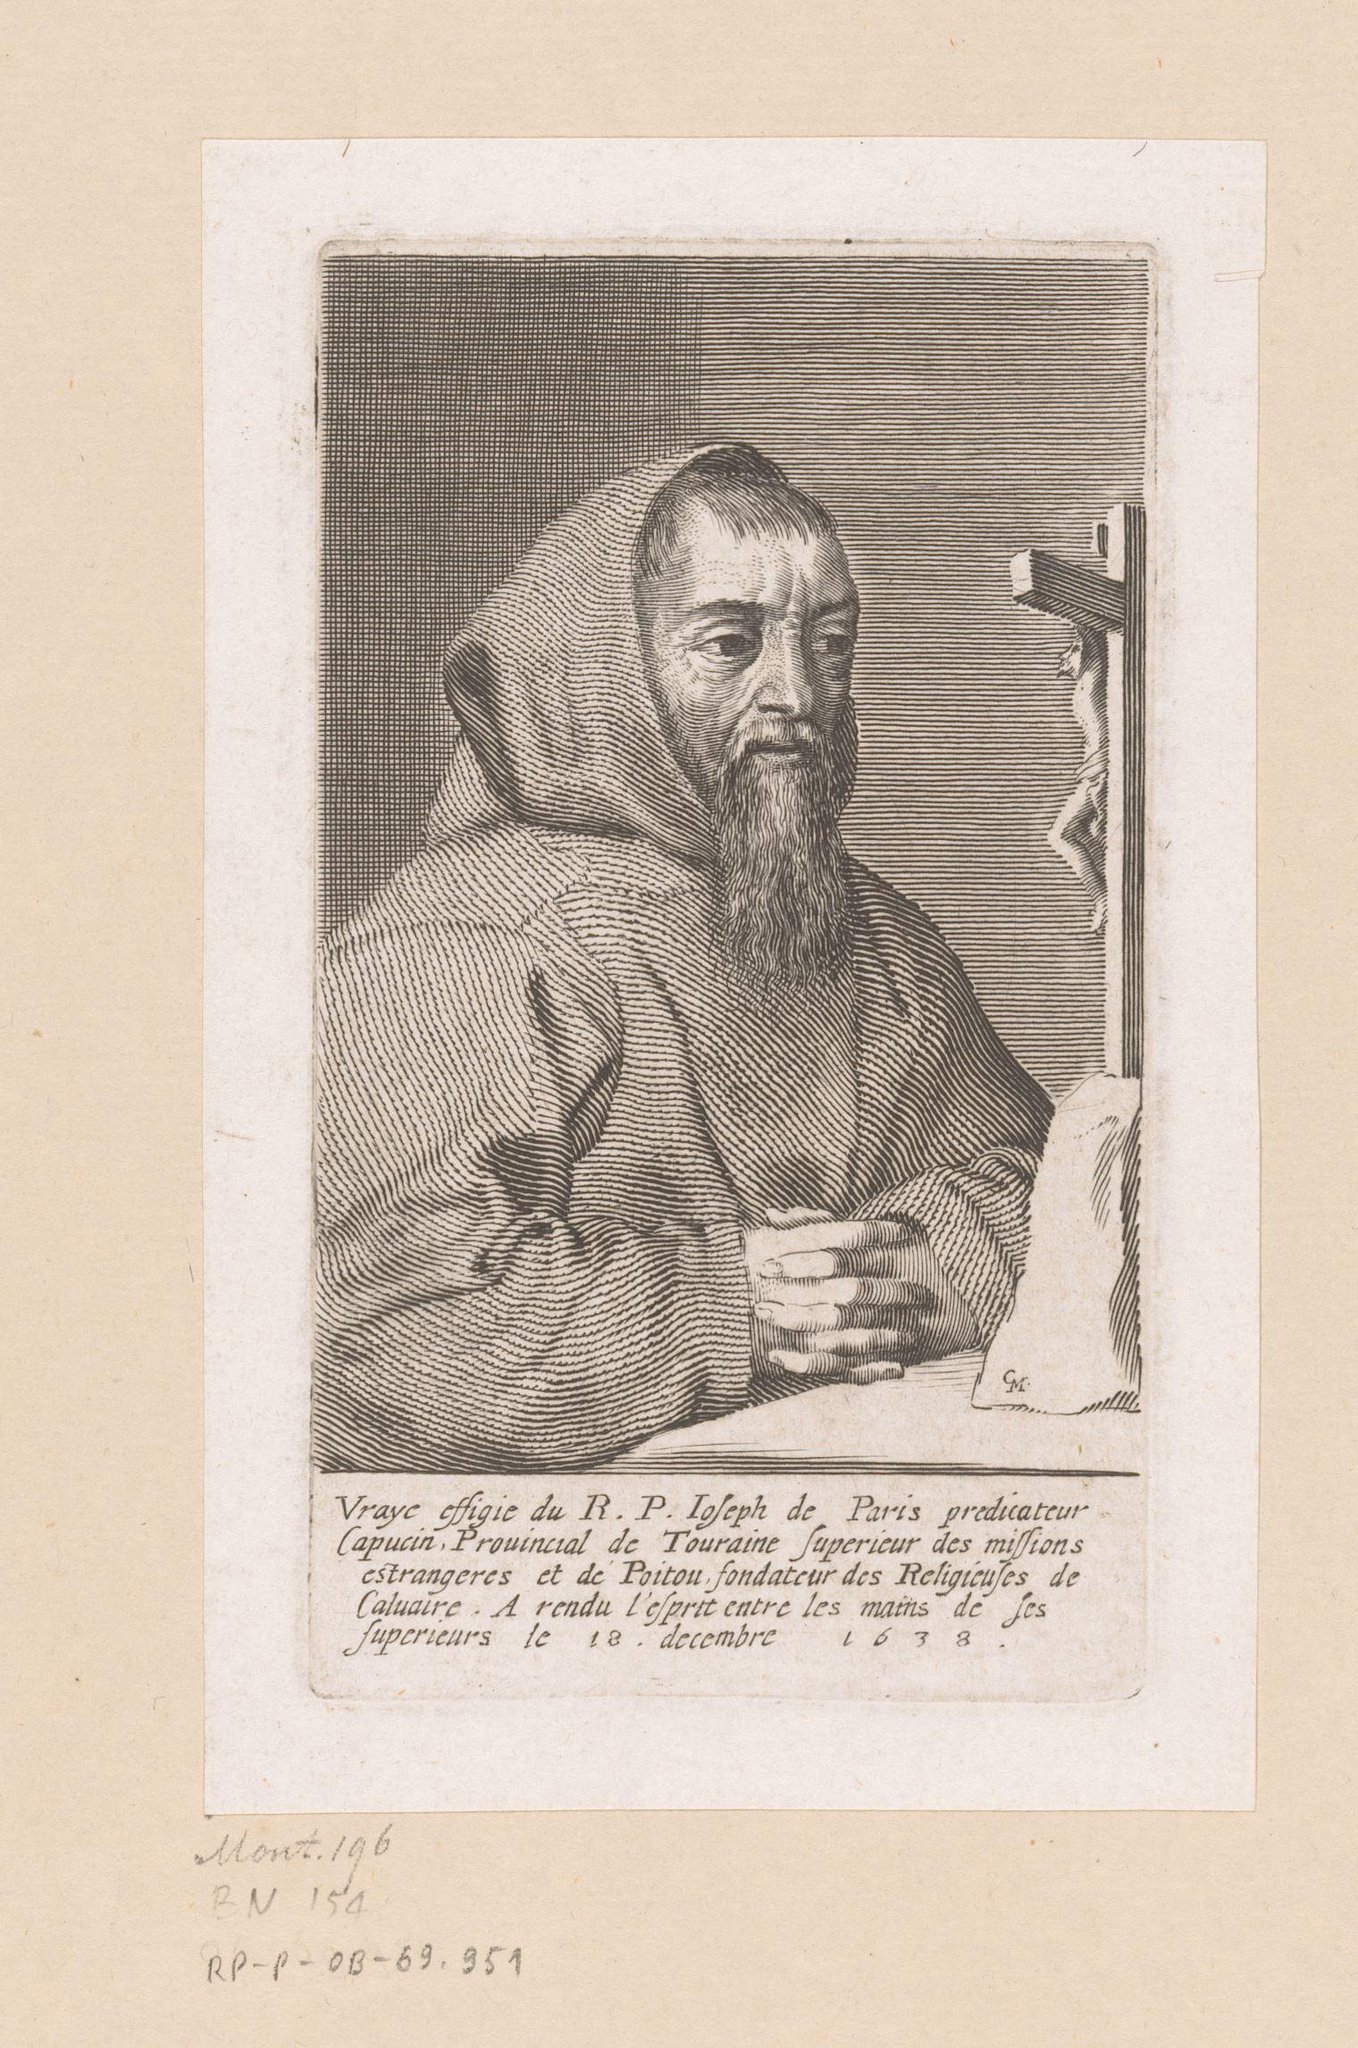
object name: print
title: Portret van François Leclerc du Tremblay, genaamd Père Joseph, bij een kruis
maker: claude mellan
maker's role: draughtsman, print maker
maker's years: 1598-1688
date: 1638-1688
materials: paper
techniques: engraving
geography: france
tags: historical persons, one person praying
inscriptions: collector's mark: Lugt 240